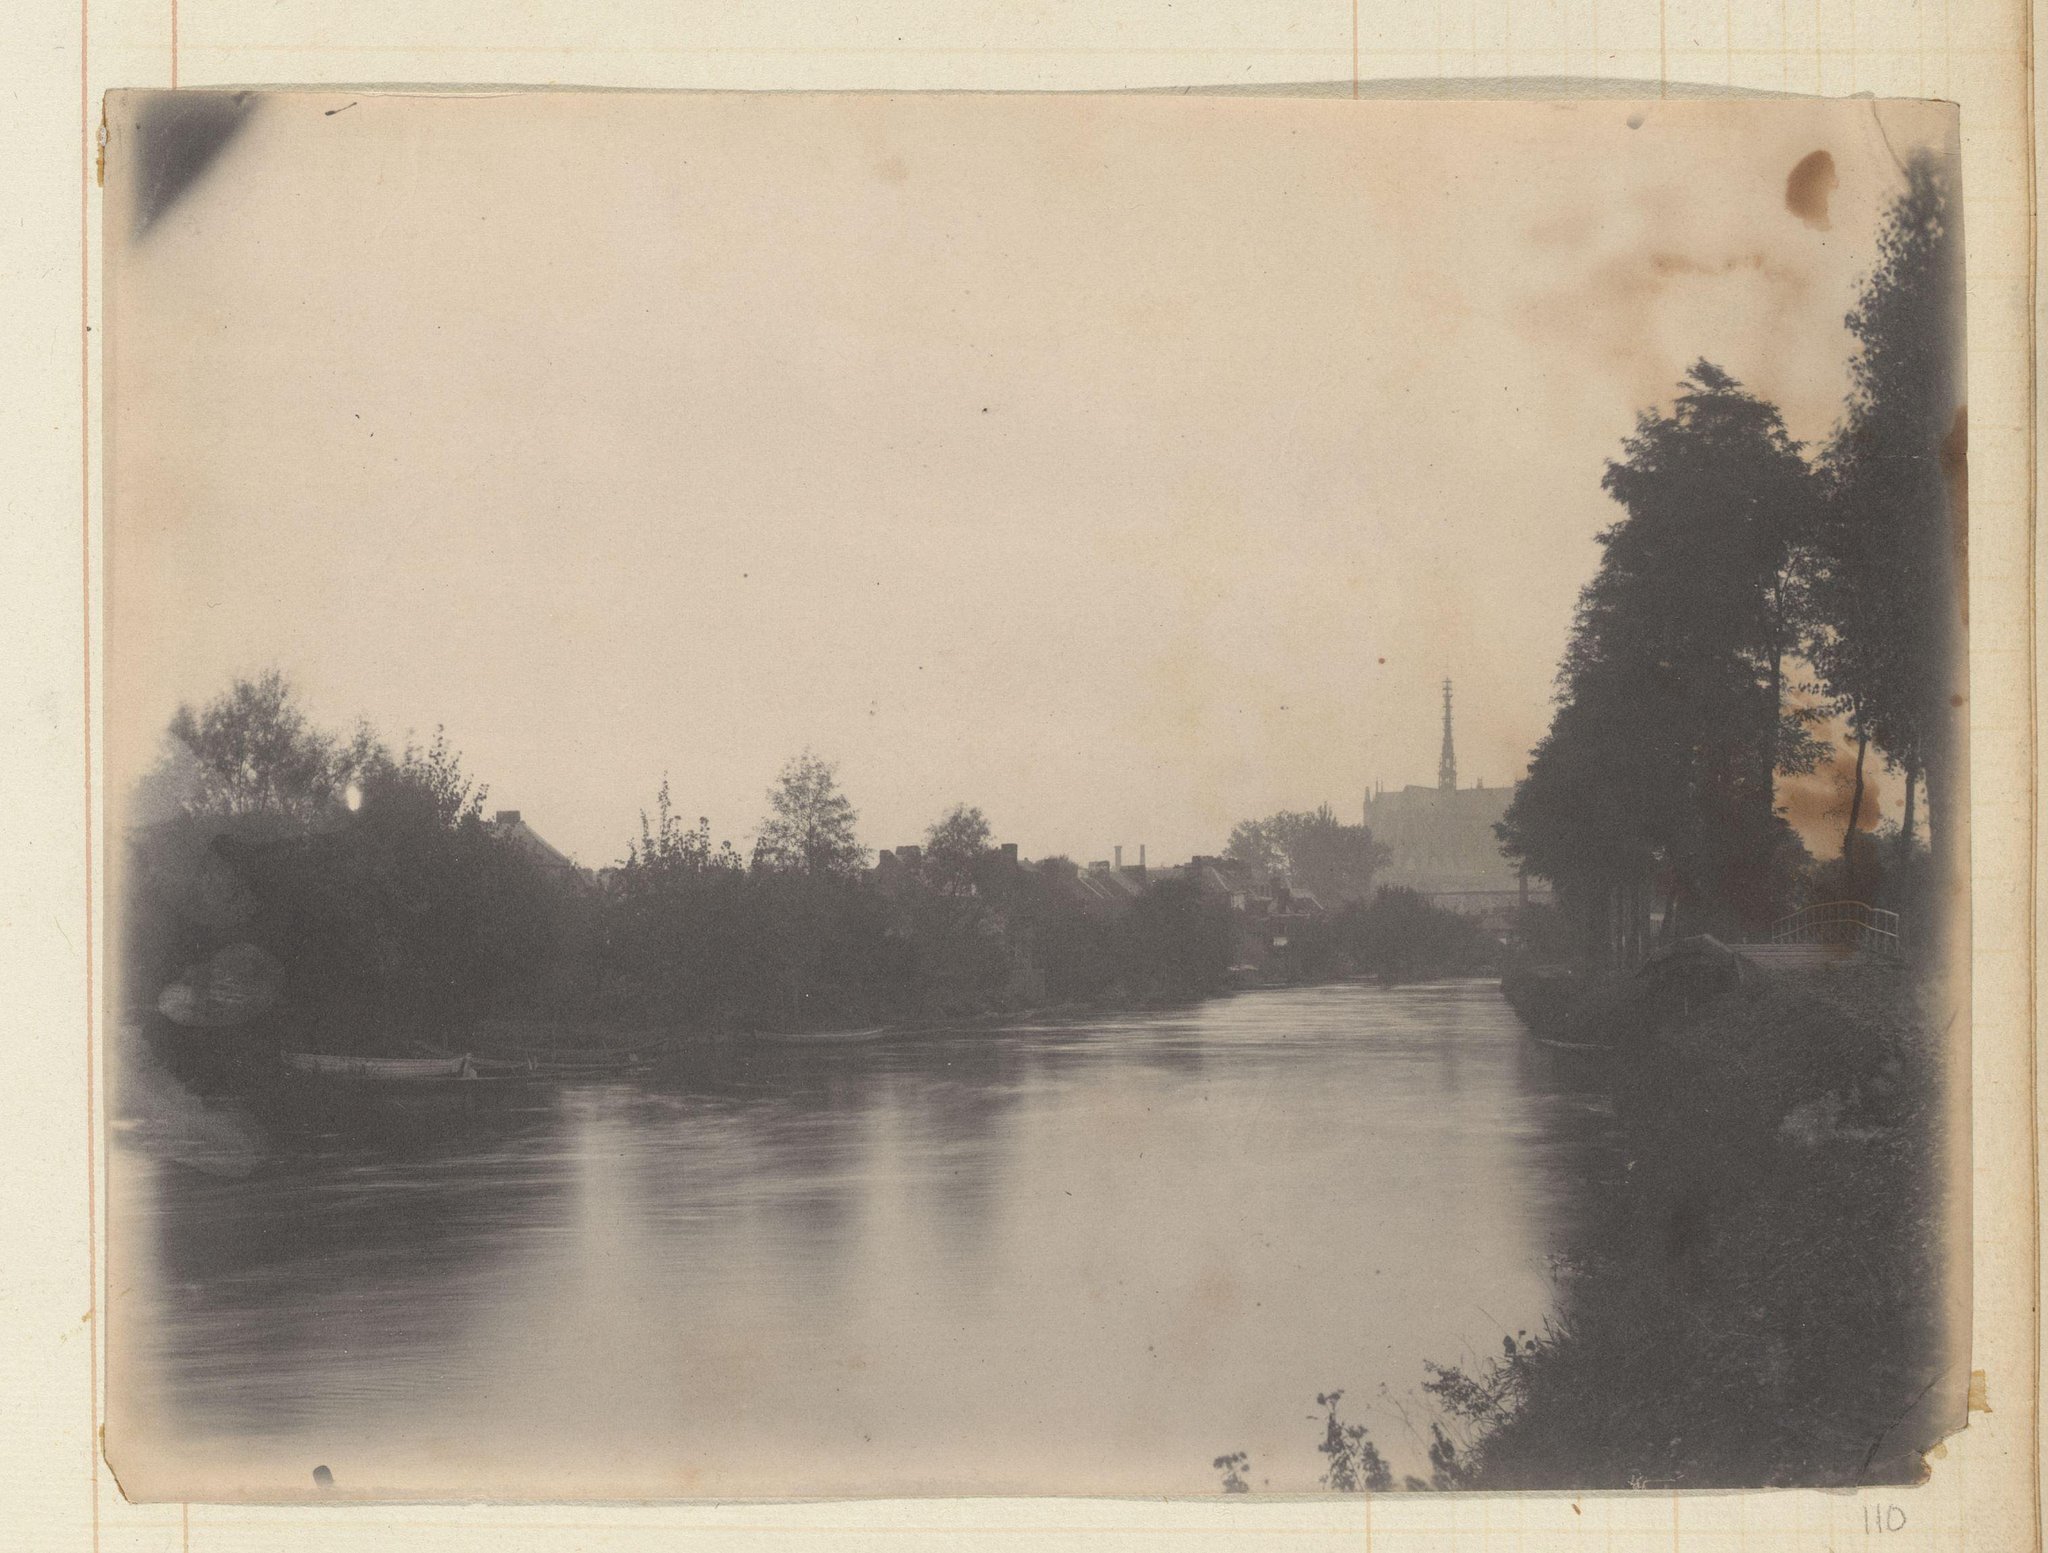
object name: photograph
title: Gezicht op een rivier met huizen, kerk en brug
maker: Anonymous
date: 1880-1900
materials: paper, photographic support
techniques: platinum process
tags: prospect of village, silhouette of village, river bank